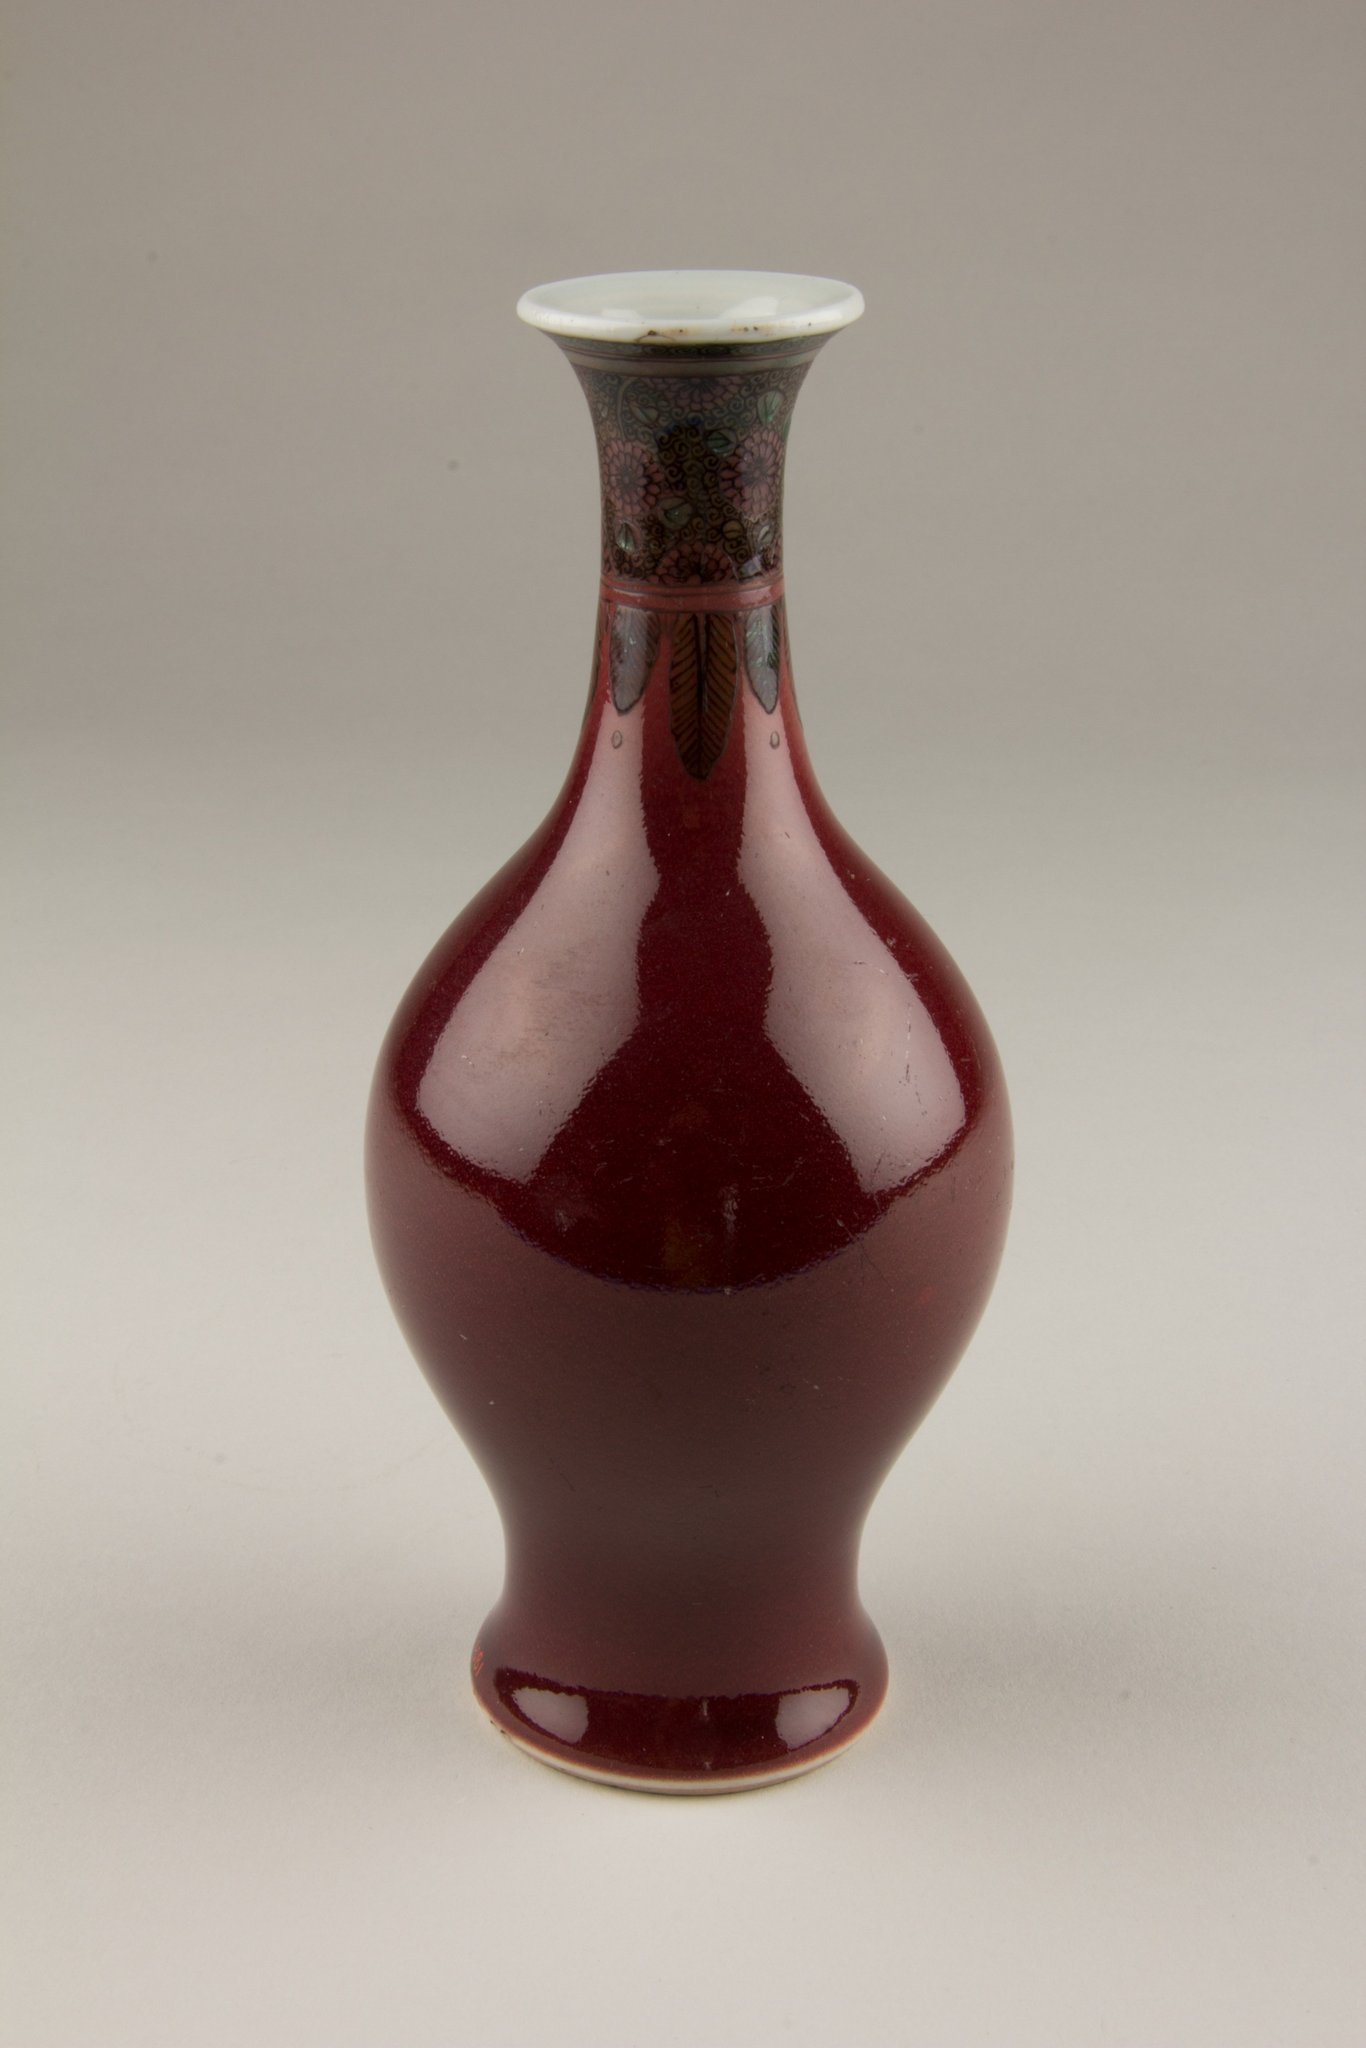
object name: vase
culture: chinese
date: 1644-1911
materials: copper, enamel, glaze, porcelain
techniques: overglaze, painting, polychrome